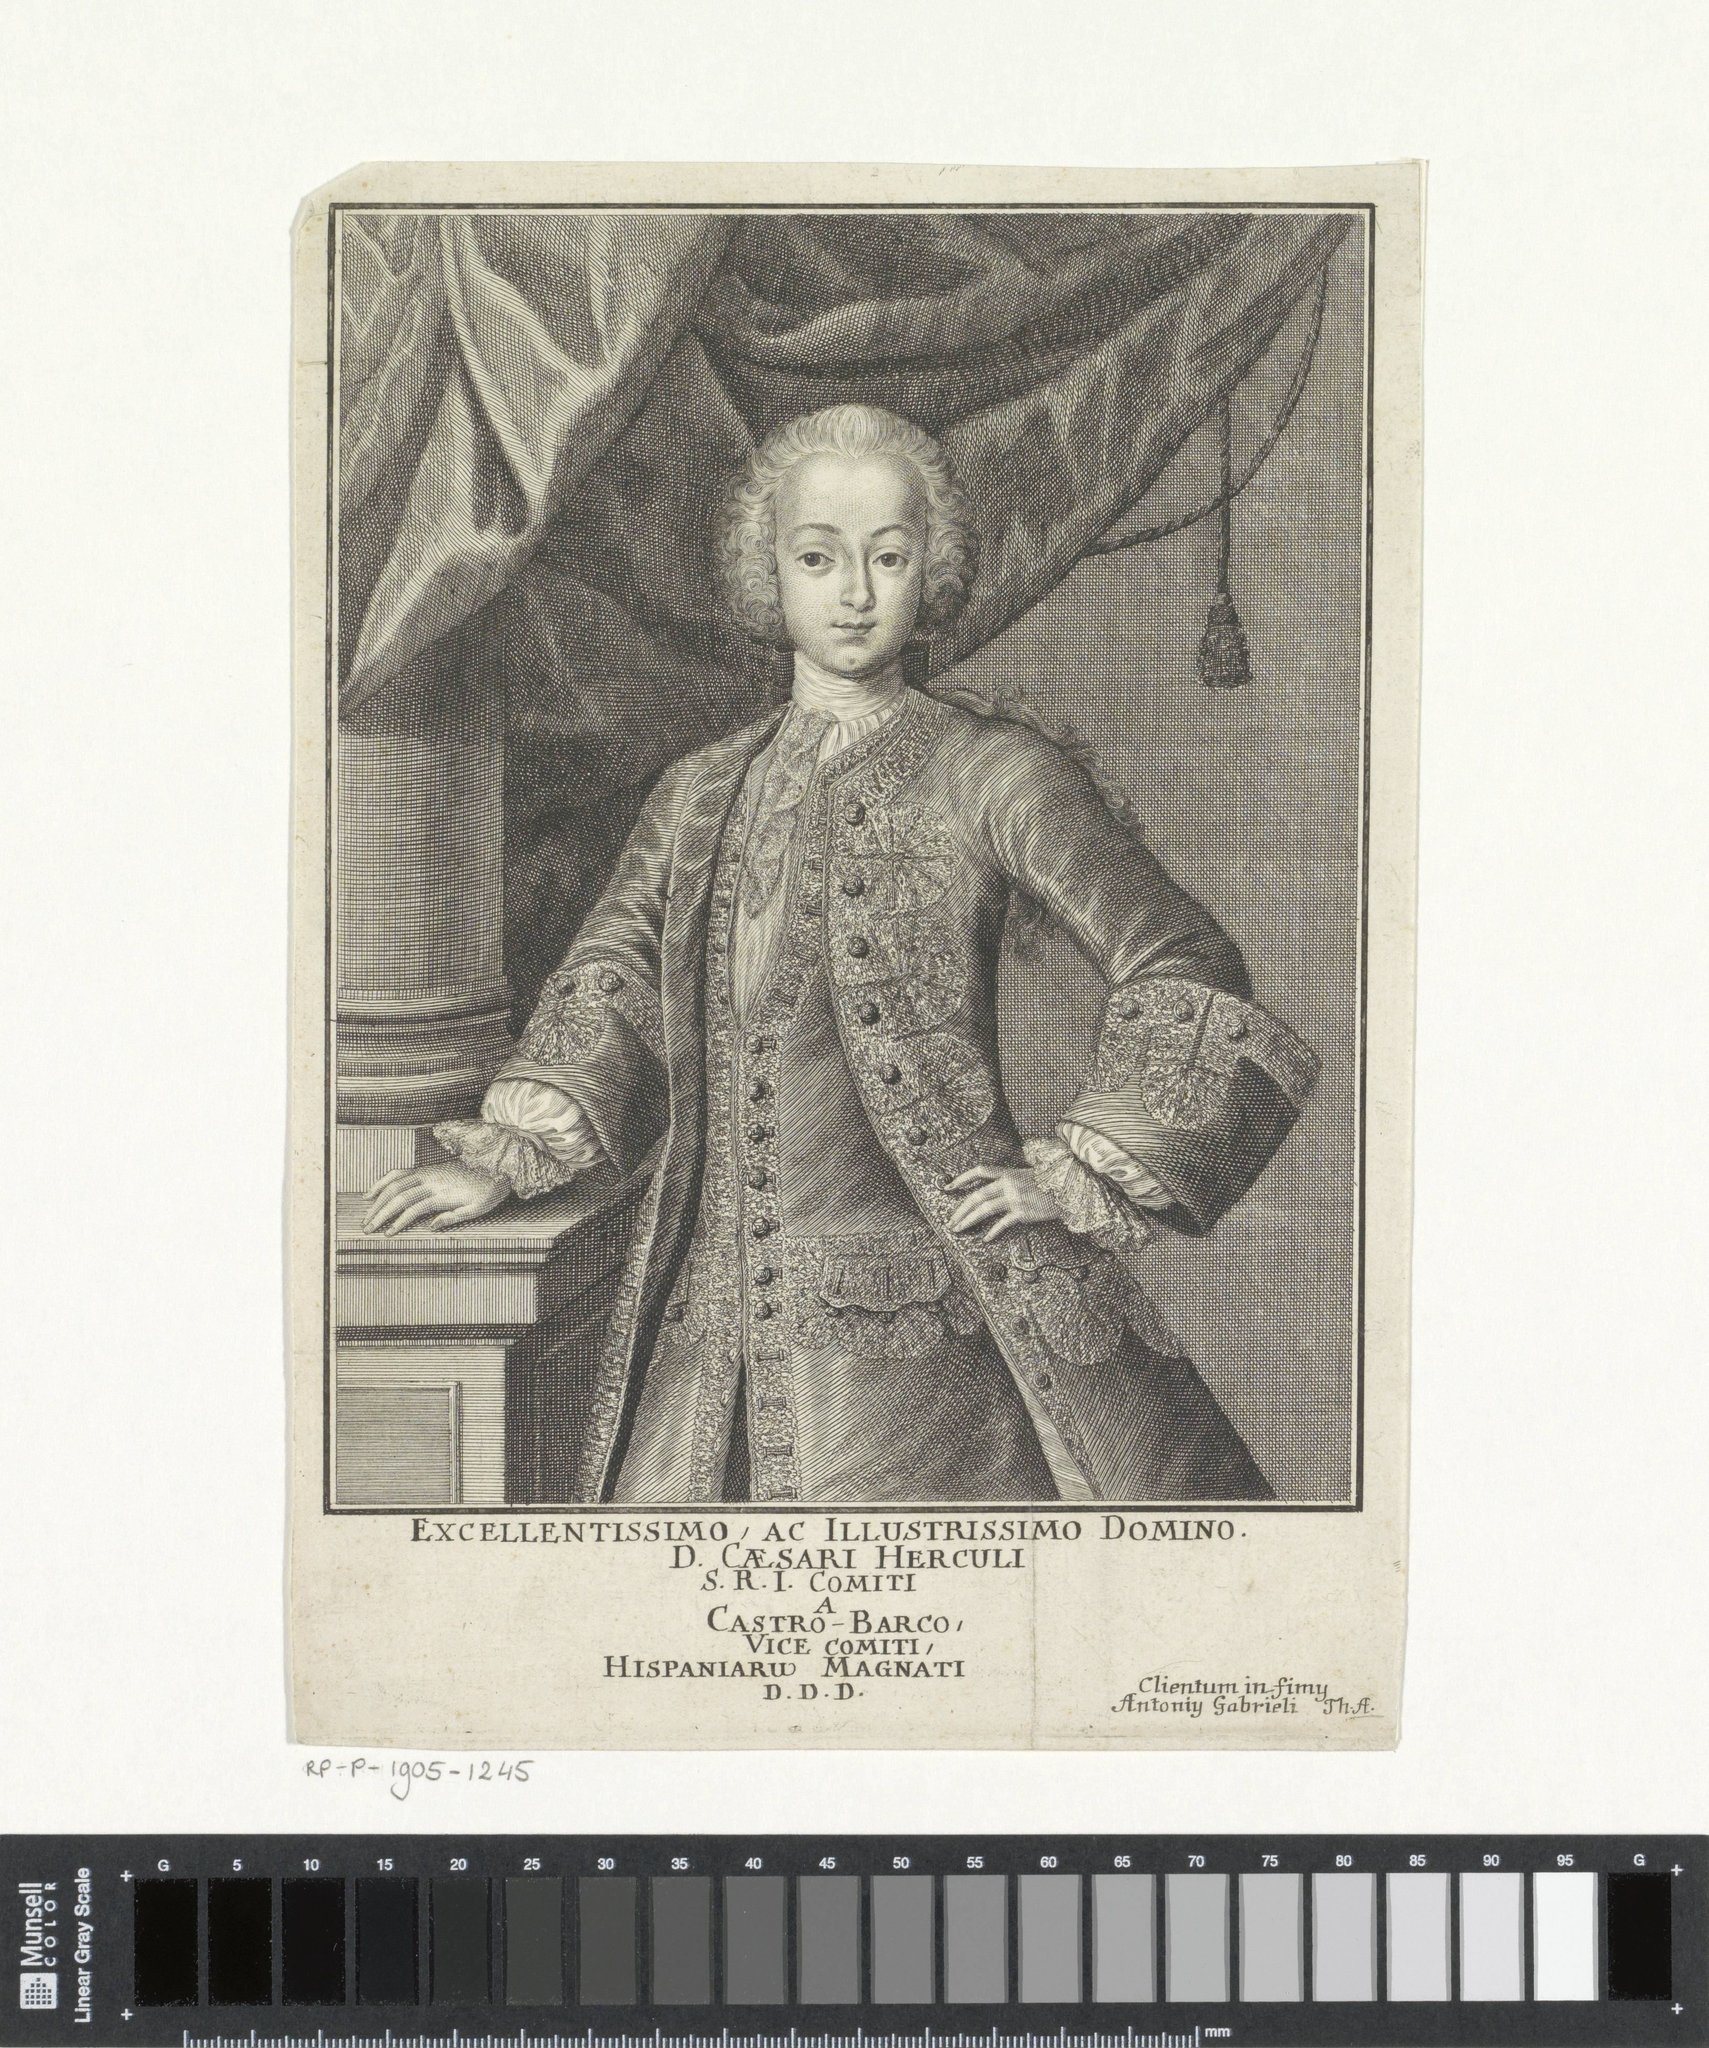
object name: print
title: Portret van Caesari Herculi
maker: antonio gabrieli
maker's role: painter, print maker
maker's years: 1694-1789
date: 1783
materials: paper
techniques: engraving, etching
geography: italy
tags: historical persons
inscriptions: collector's mark: Lugt 2228